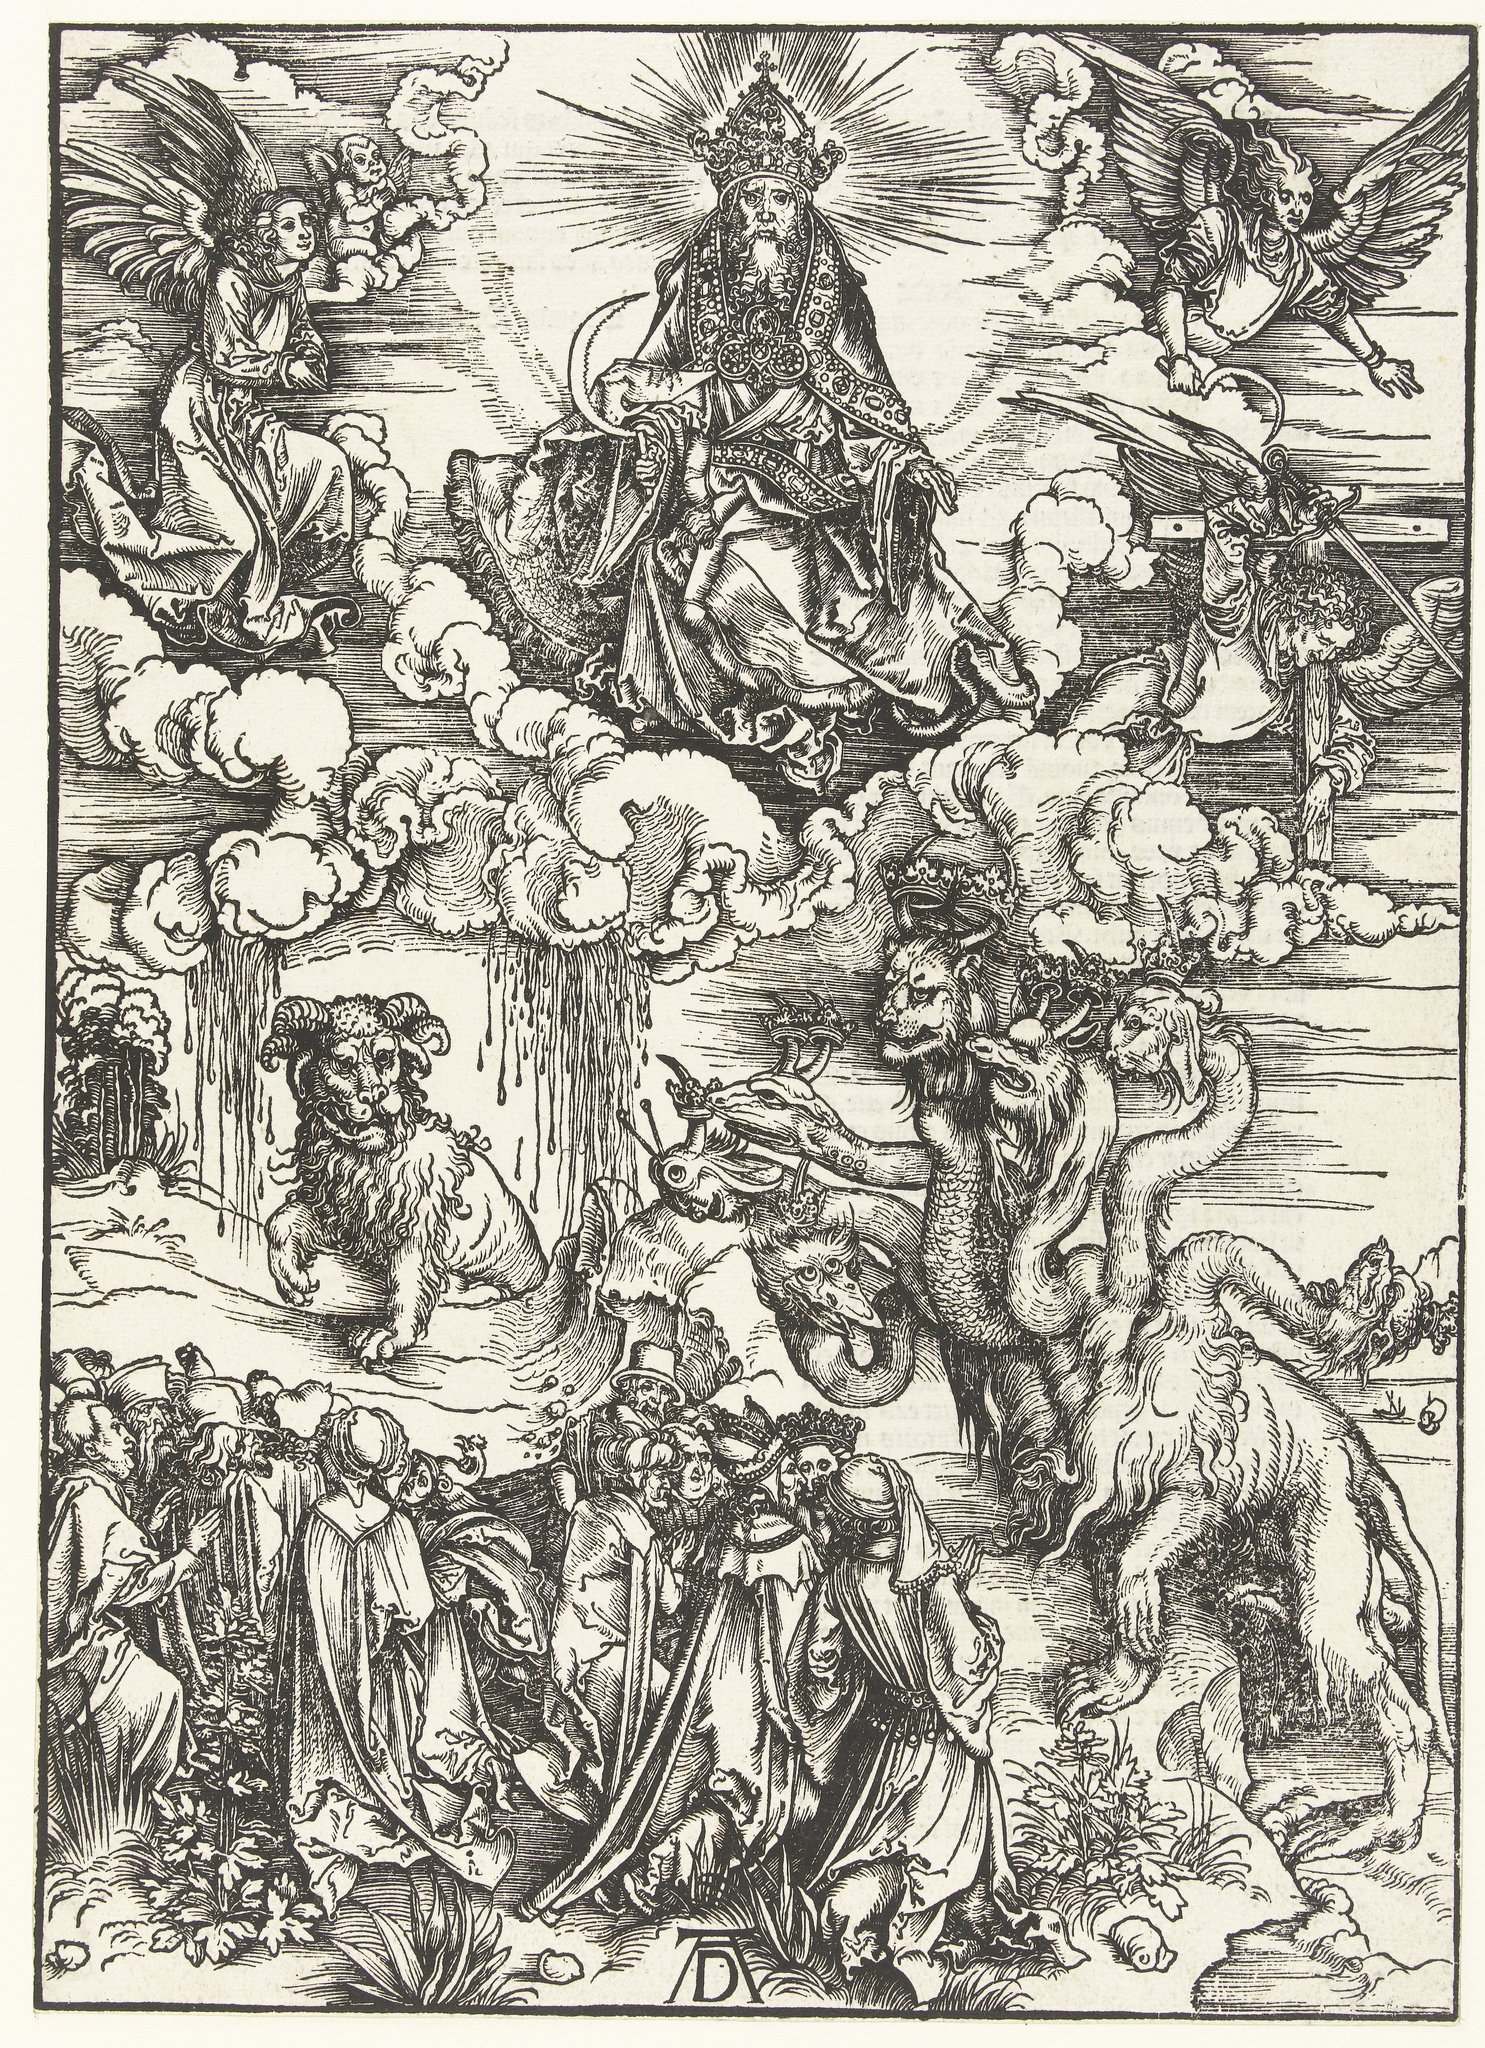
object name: print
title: Christus met een sikkel, het beest met de hoorns als van een lam en de zevenkoppige draak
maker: albrecht dürer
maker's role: draughtsman, painter, print maker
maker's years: 1471-1528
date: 1496-1497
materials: paper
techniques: letterpress printing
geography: nuremberg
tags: the two-horned beast out of the earth and the beast out of the sea are worshipped, the son of man (christ) with the sickle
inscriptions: collector's mark: Lugt 240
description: Christus troont in de hemel, een sikkel in de rechterhand en omgeven door vier engelen. Onder hem staan een beest met de kop van een leeuw en hoorns als van een lam, en een zevenkoppige draak, die door een mensenmenigte aanbeden wordt. Op versozijde Latijnse bijbeltekst in gotisch schrift in twee kolommen.